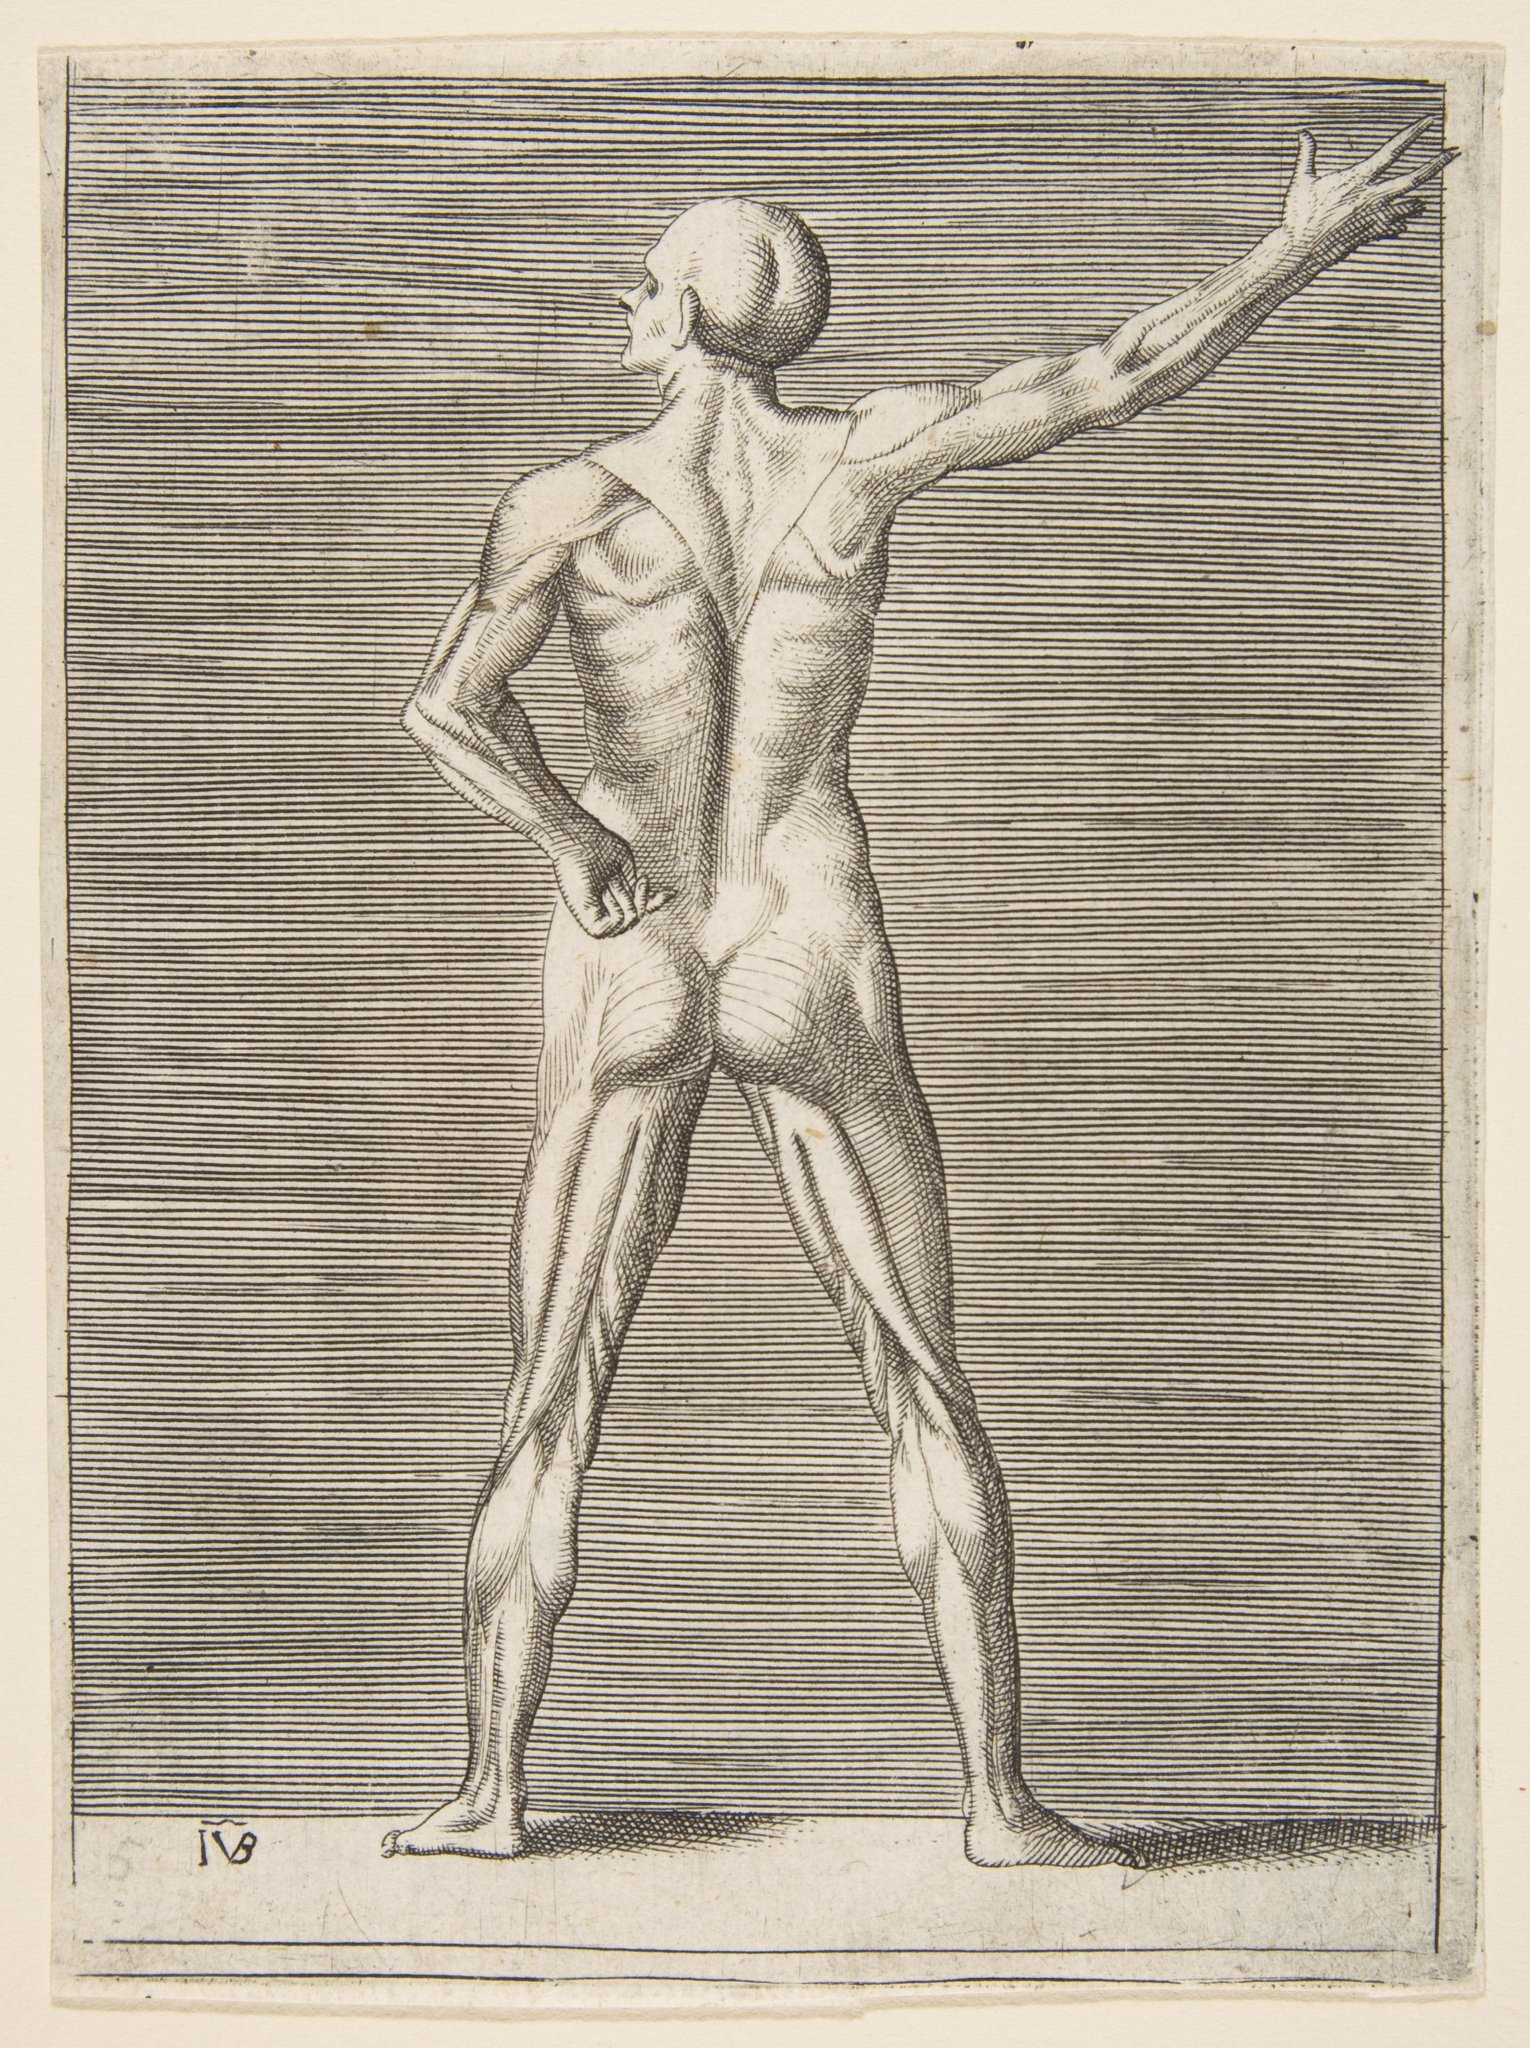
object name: print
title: Flayed man seen from the back, his right arm extended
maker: giulio bonasone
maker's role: artist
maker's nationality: italian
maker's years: 1510-1576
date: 1531-1576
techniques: engraving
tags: male nudes